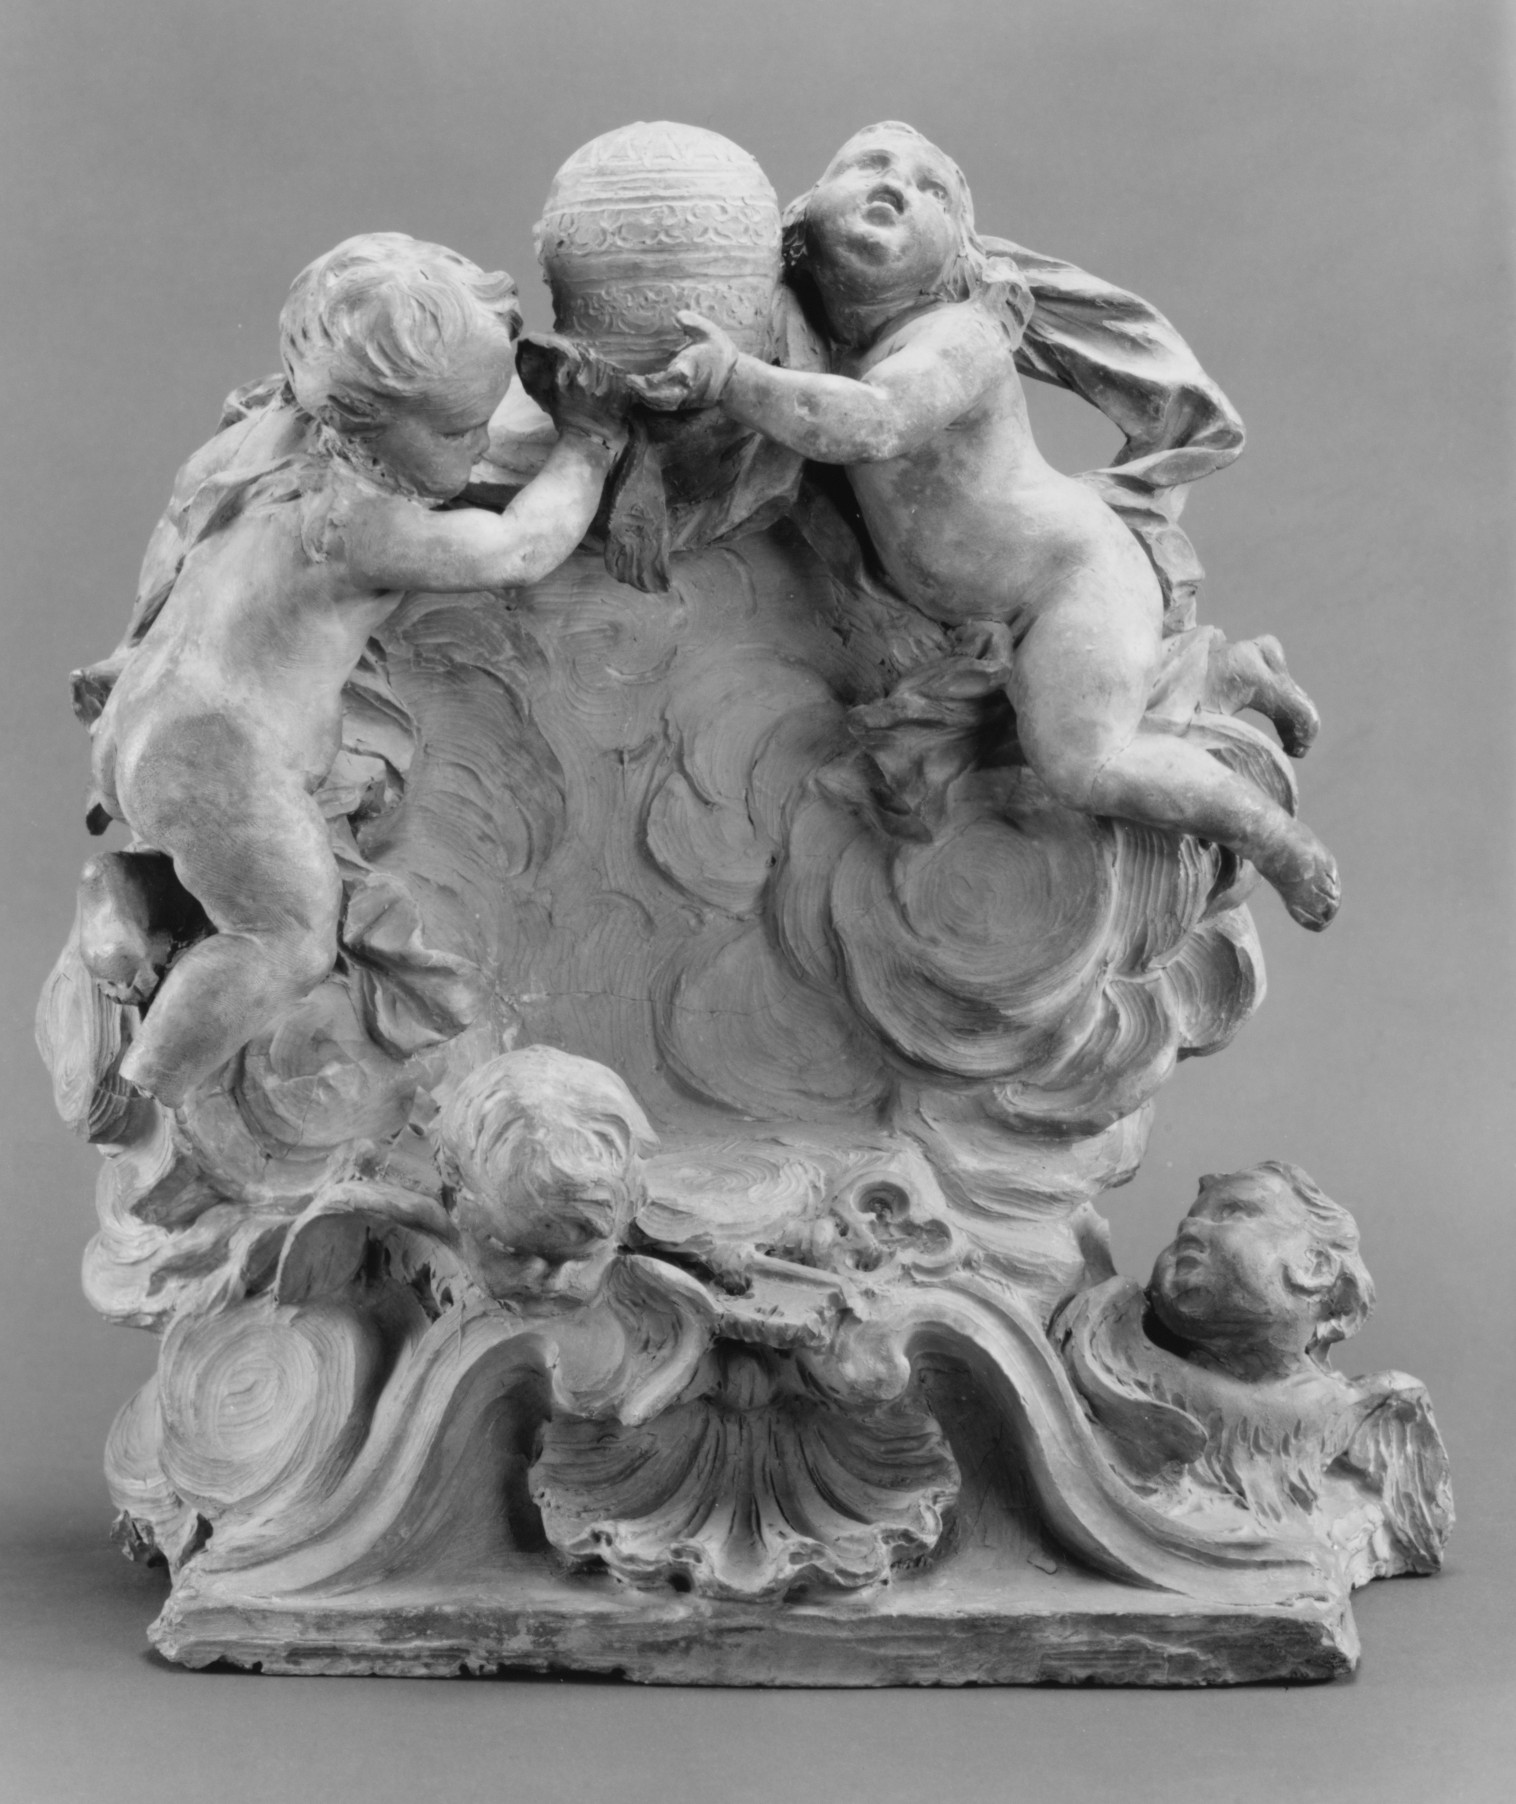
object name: sculpture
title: Model for a Papal monument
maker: peter anton von verschaffelt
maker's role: artist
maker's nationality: flemish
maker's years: 1710-1793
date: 1740-1750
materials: terracotta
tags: putti